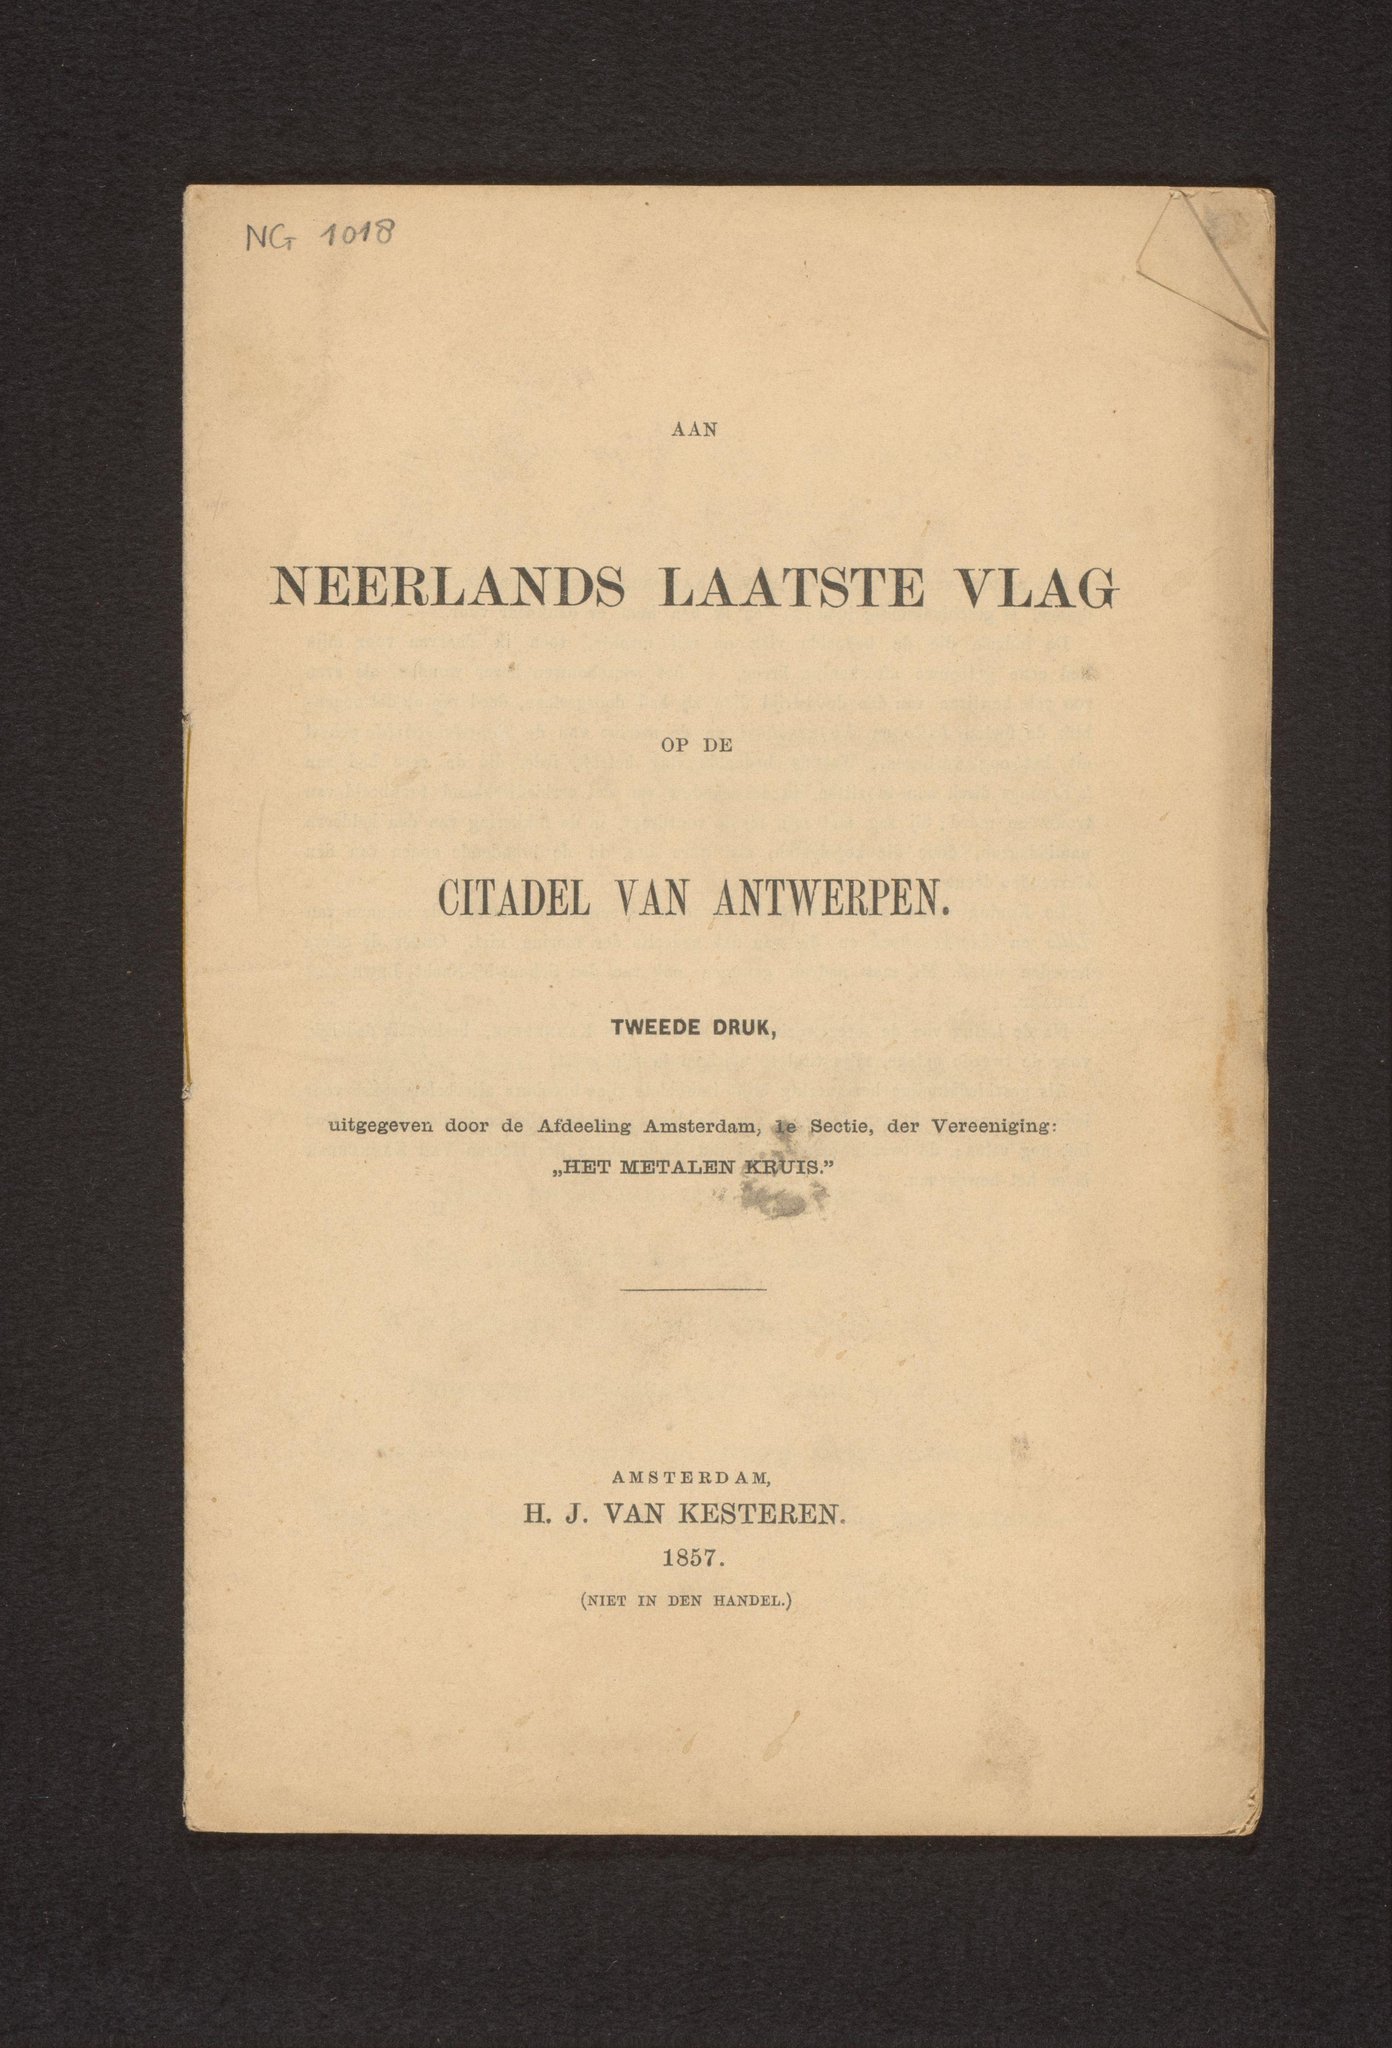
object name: brochure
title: Aan Nederlands laatste vlag op de citadel van Antwerpen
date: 1857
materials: paper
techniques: printing, sewing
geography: amsterdam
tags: citadel van antwerpen (19e eeuw), strijd om de citadel van antwerpen (1832), belgische revolutie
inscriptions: date